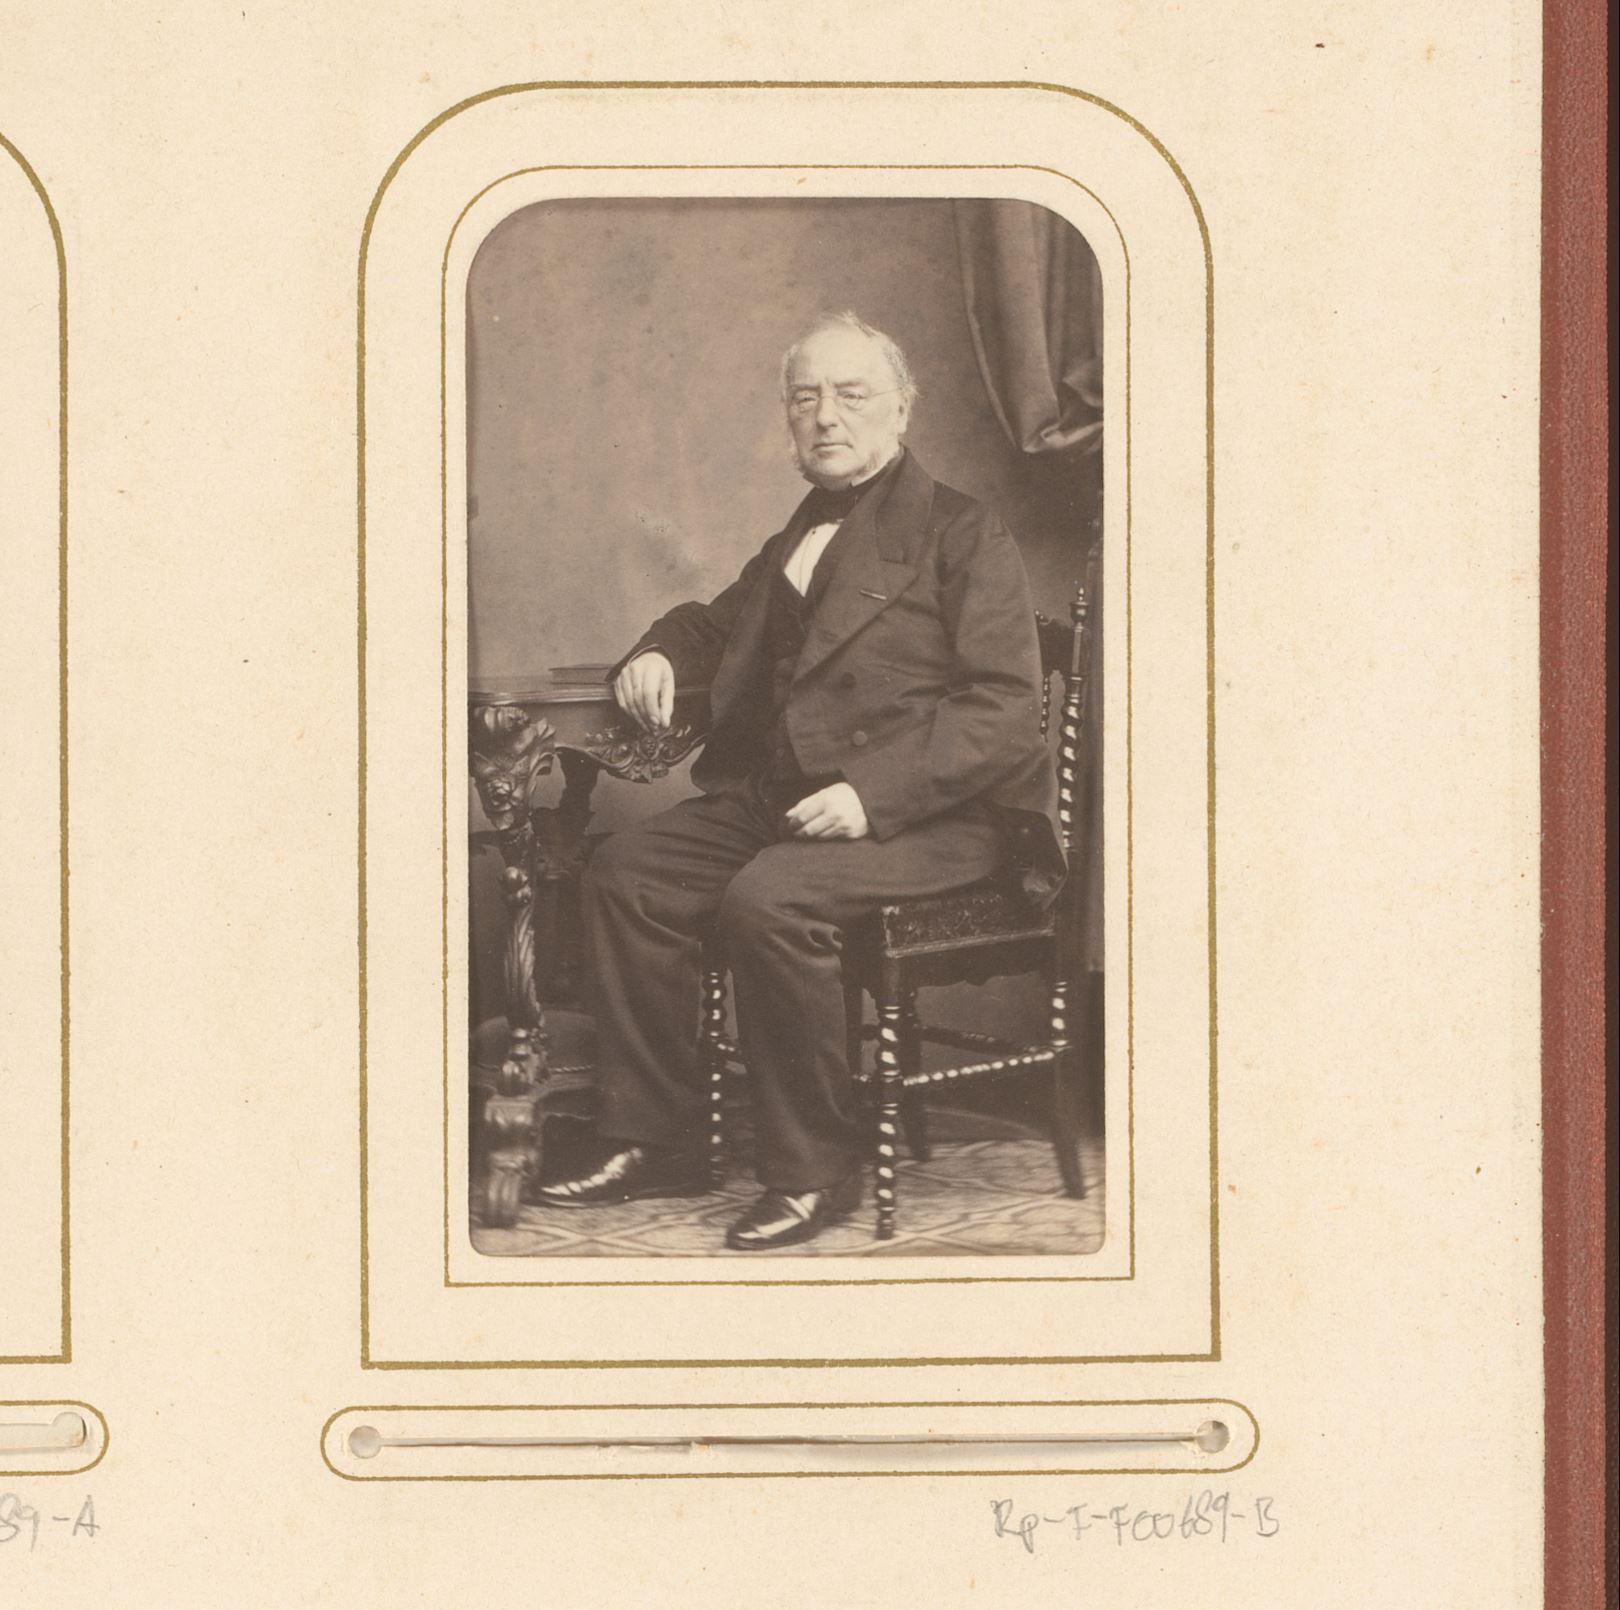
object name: album leaf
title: Portret van een zittende man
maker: Anonymous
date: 1860-1900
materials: cardboard, photographic support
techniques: albumen print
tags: historical persons